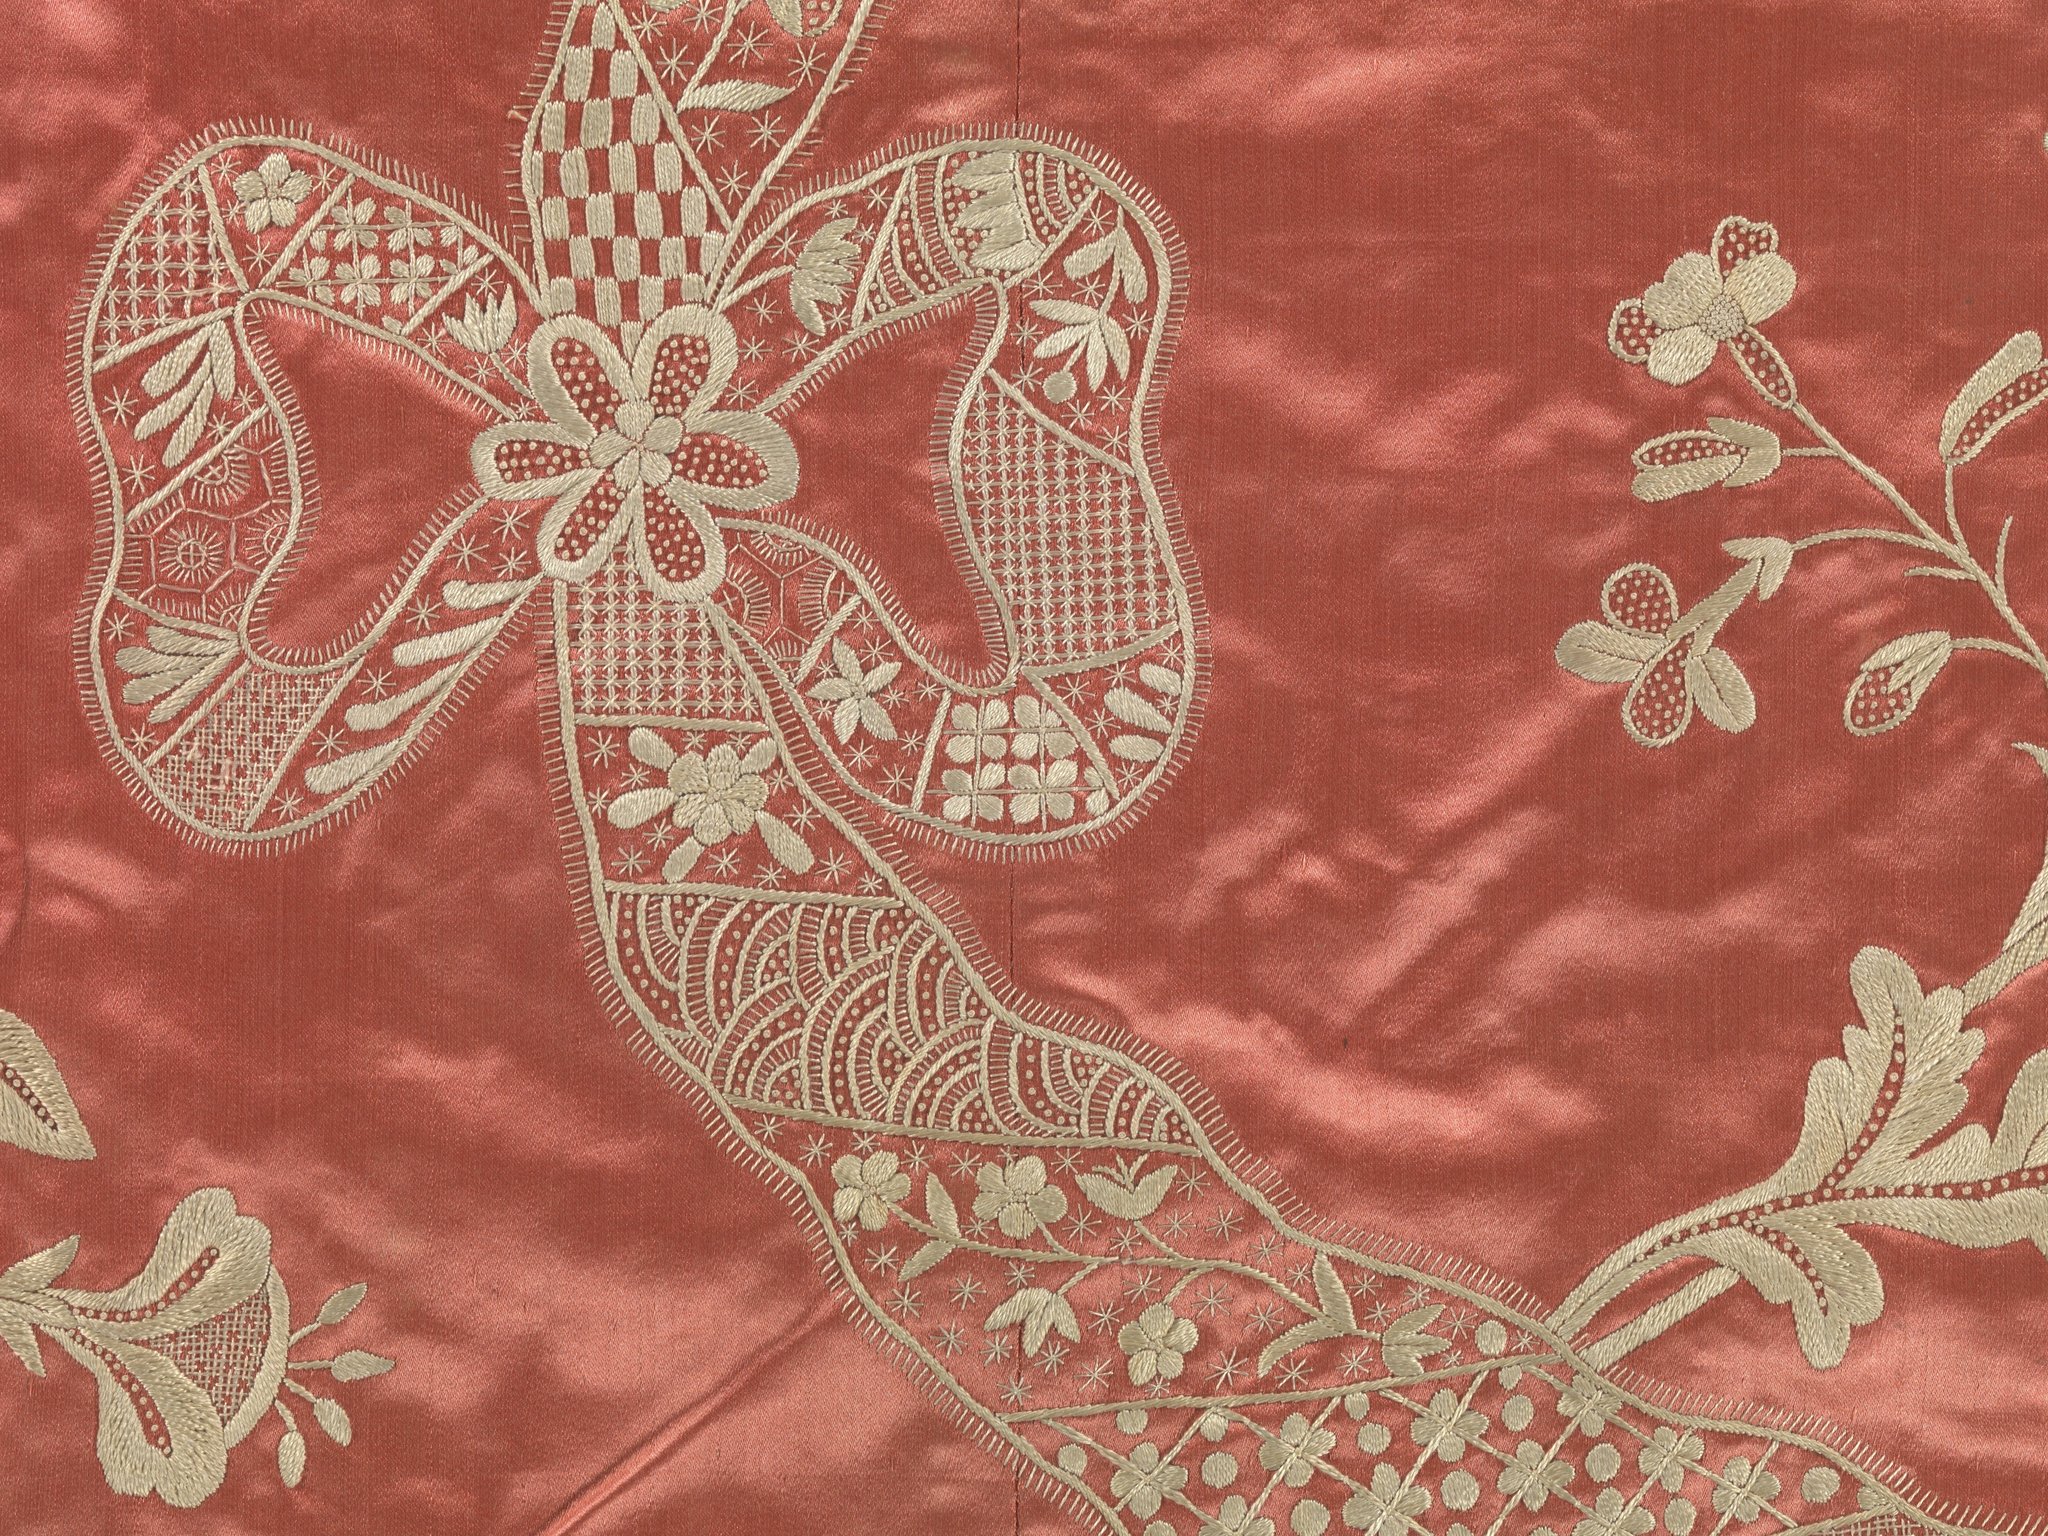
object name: cloth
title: Embroidered Interior Textile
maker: Anonymous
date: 1750-1760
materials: silk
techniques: embroidered, weave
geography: france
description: Doek bestaande uit zeven verschillende panden zijdeweefsel in roze met over de panelen heen crémekleurige geborduurde bloemen en slingerende kantmotieven met strikken. Rechts en links bovenaan meerdere ingezette hoeken van dezelfde stof (hier loopt het borduurwerk niet over de naden heen door).